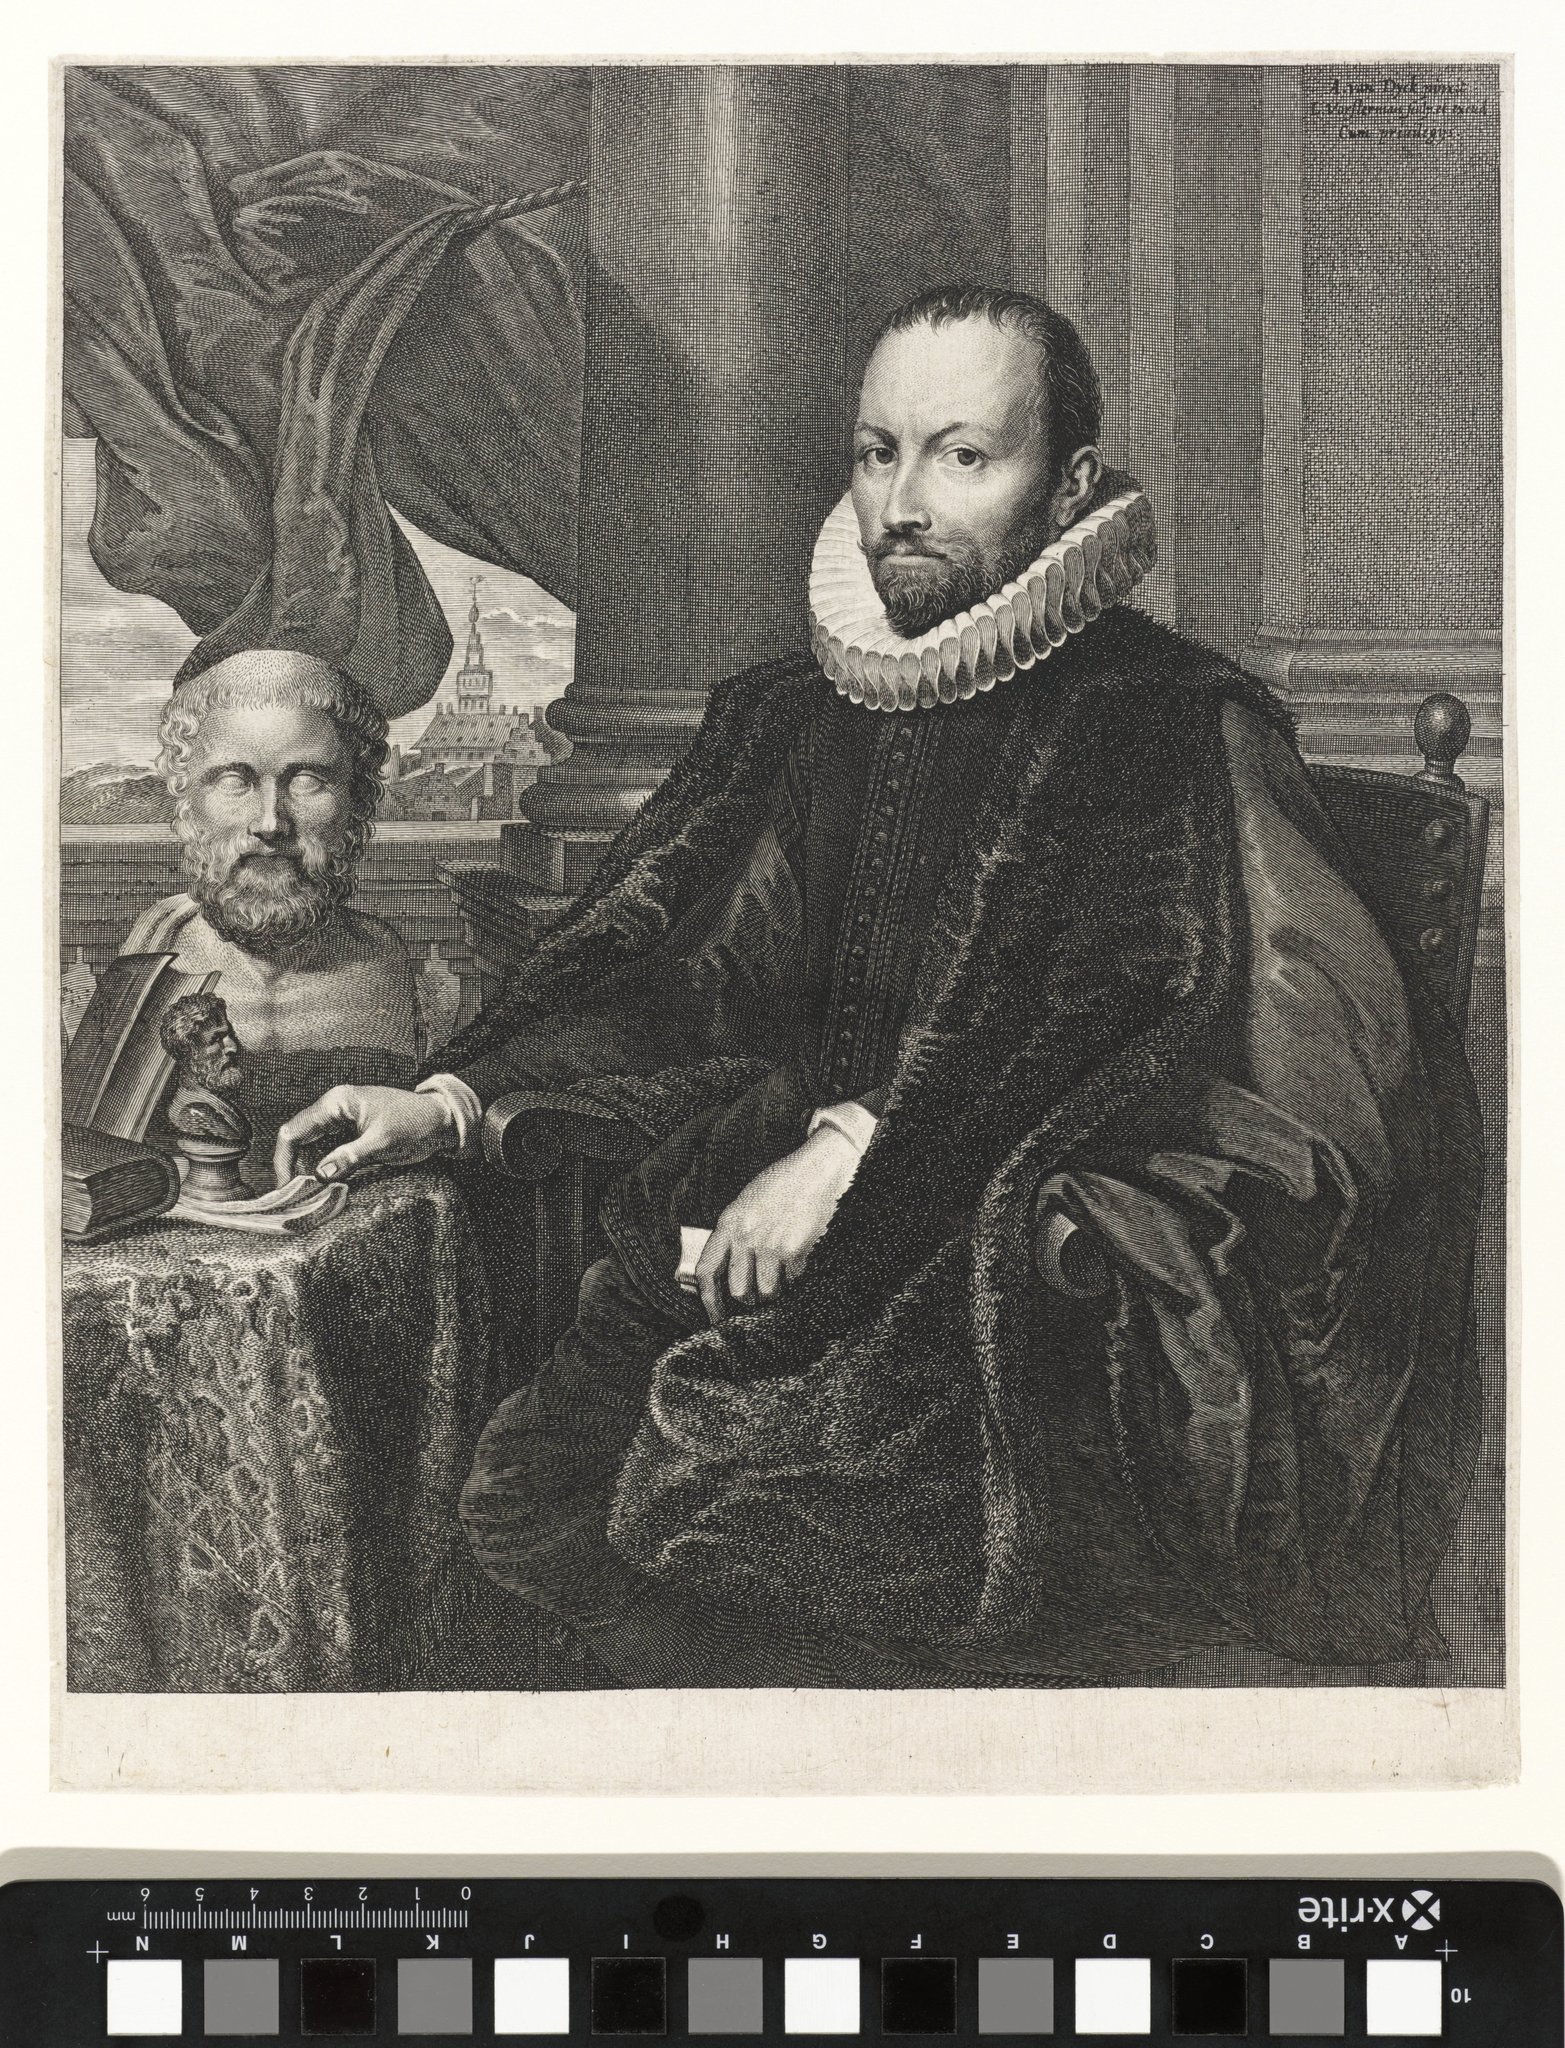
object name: print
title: Portret van Nikolaas Rockox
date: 1625-1666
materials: paper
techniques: engraving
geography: antwerp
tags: antwerp, mayor, nikolaas rockox, (story of) demosthenes - portrait of person from classical history (+ full face)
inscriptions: collector's mark: Lugt 240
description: Portret van Nikolaas Rockox, burgemeester van Antwerpen en kunstliefhebber. Hij zit in een interieur met voor hem op tafel boeken en kunstvoorwerpen, waaronder een buste van de Griekse redenaar en politicus Demosthenes.